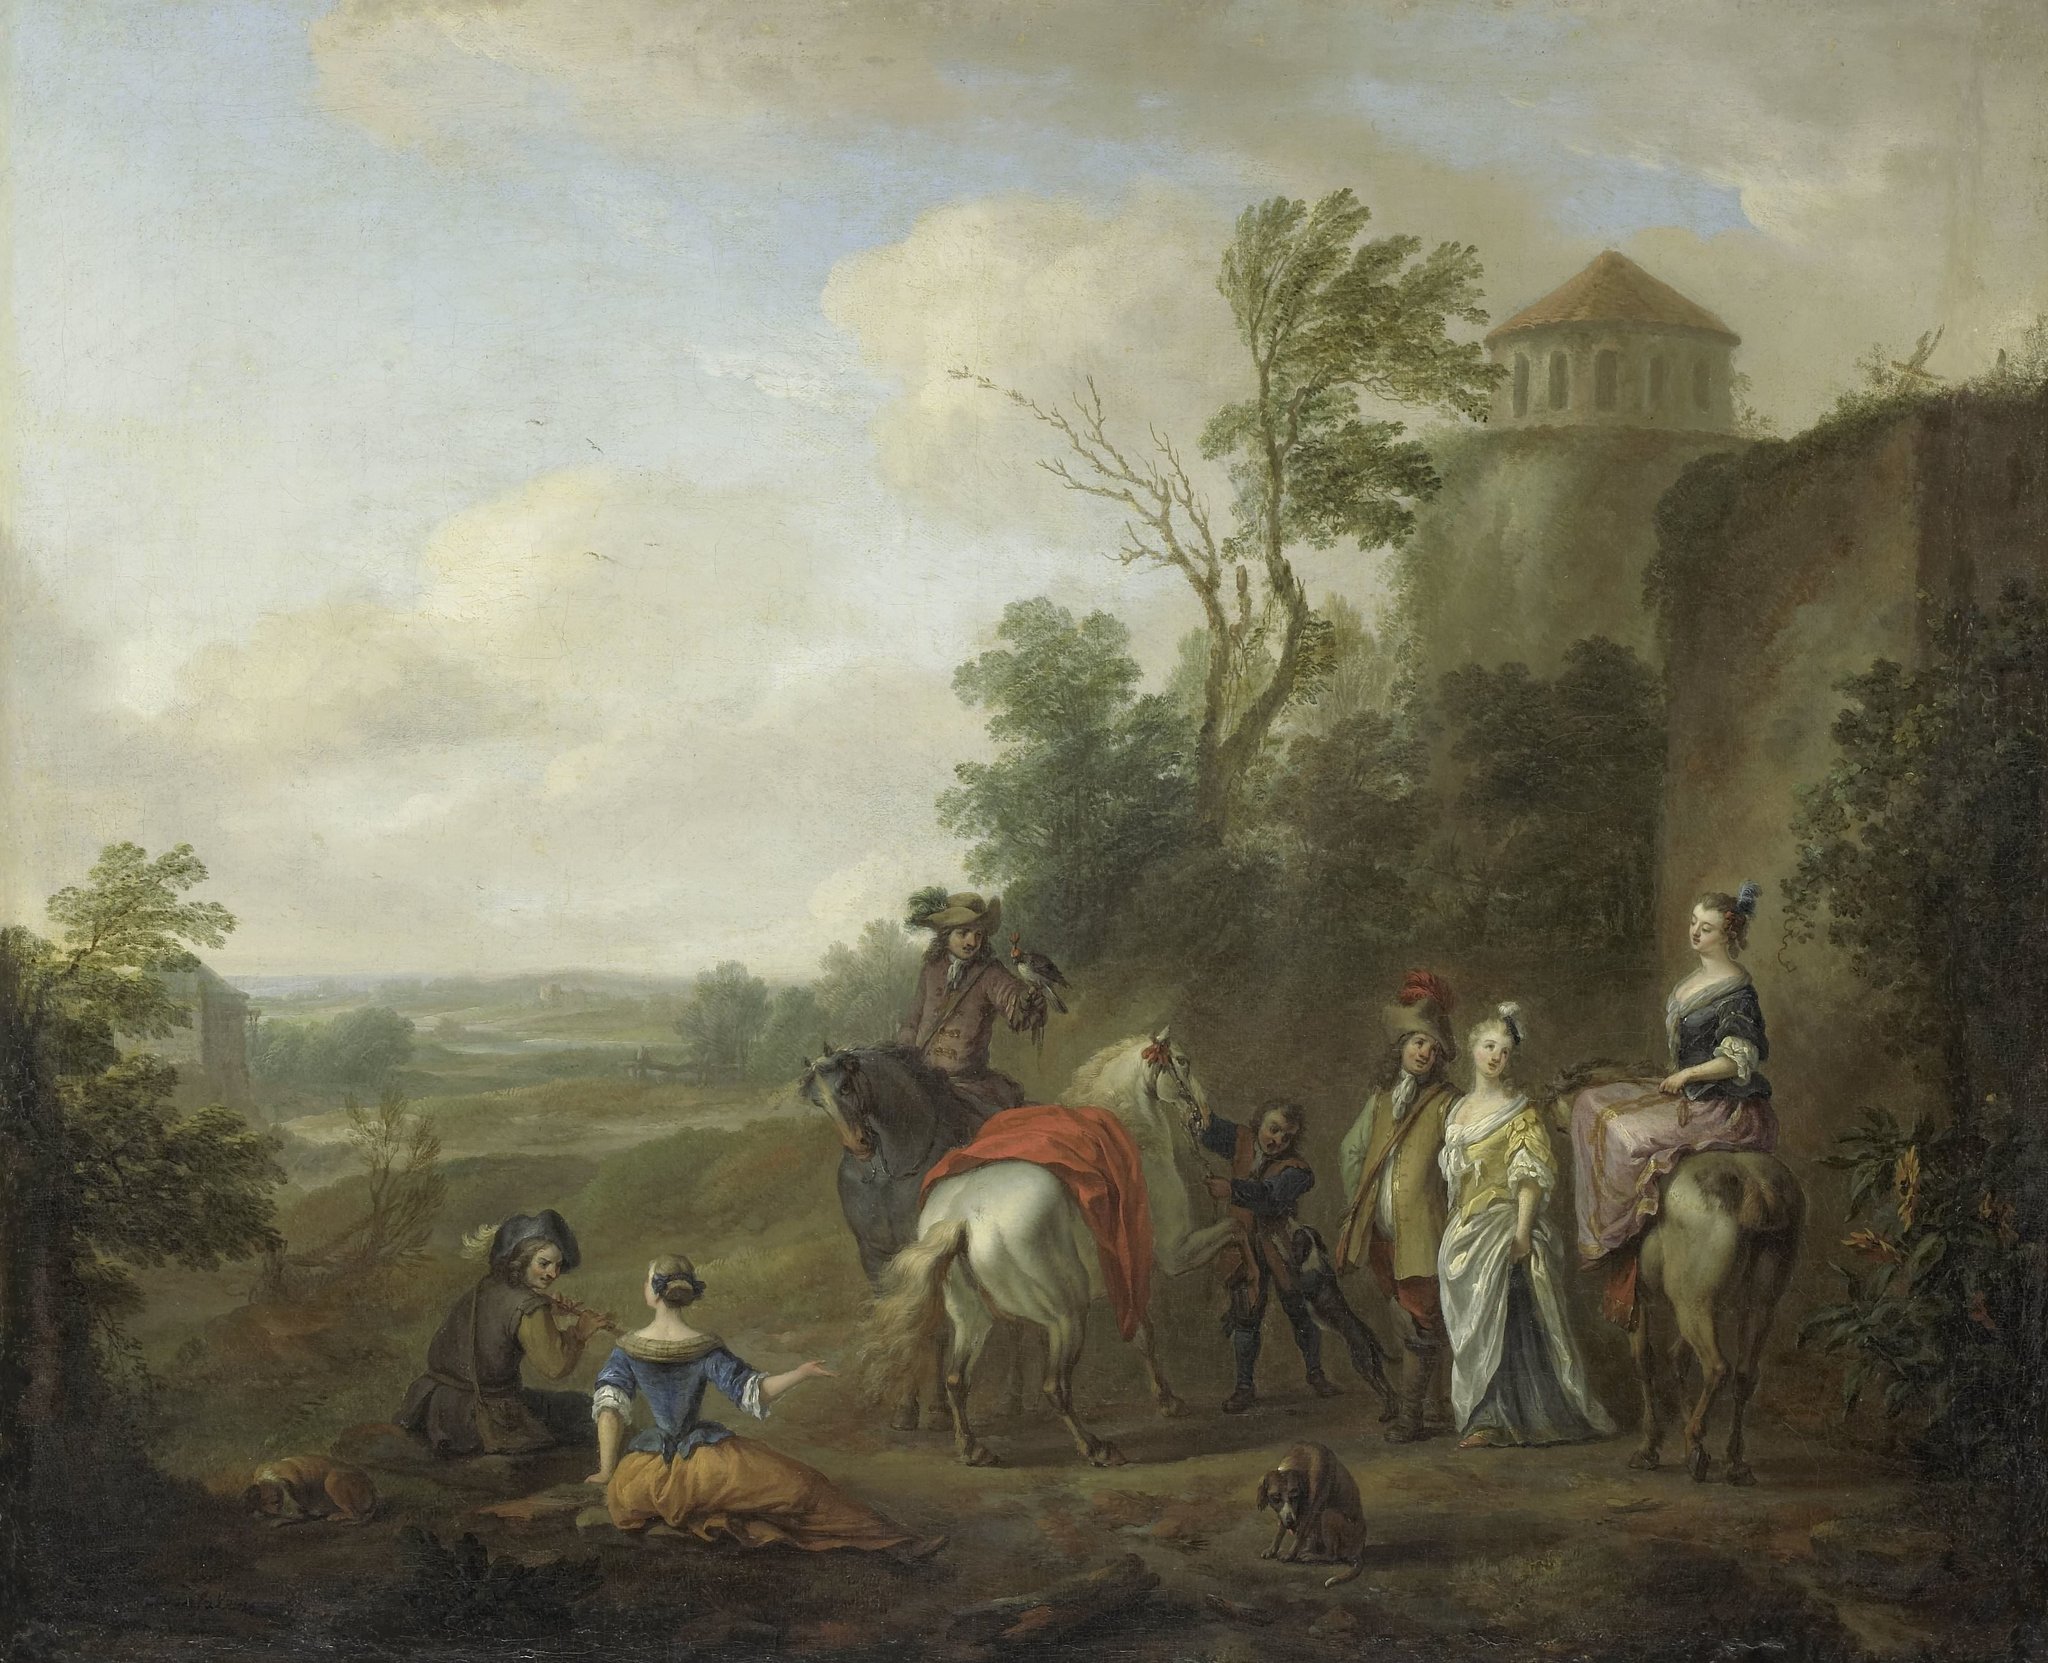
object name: painting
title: A Hunting Party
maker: karel van falens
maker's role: draughtsman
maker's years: 1683-1733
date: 1700-1733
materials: canvas, oil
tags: assembling, 'départ pour la chasse', return from the hunt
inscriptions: signature: ‘c. van falens’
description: Landschap waarin een jachtgezelschap zich voorbereidt op, of rust tijdens de valkenjacht. Drie paren en een knecht met jachthonden. enkele figuren te paard, anderen staan of zitten.